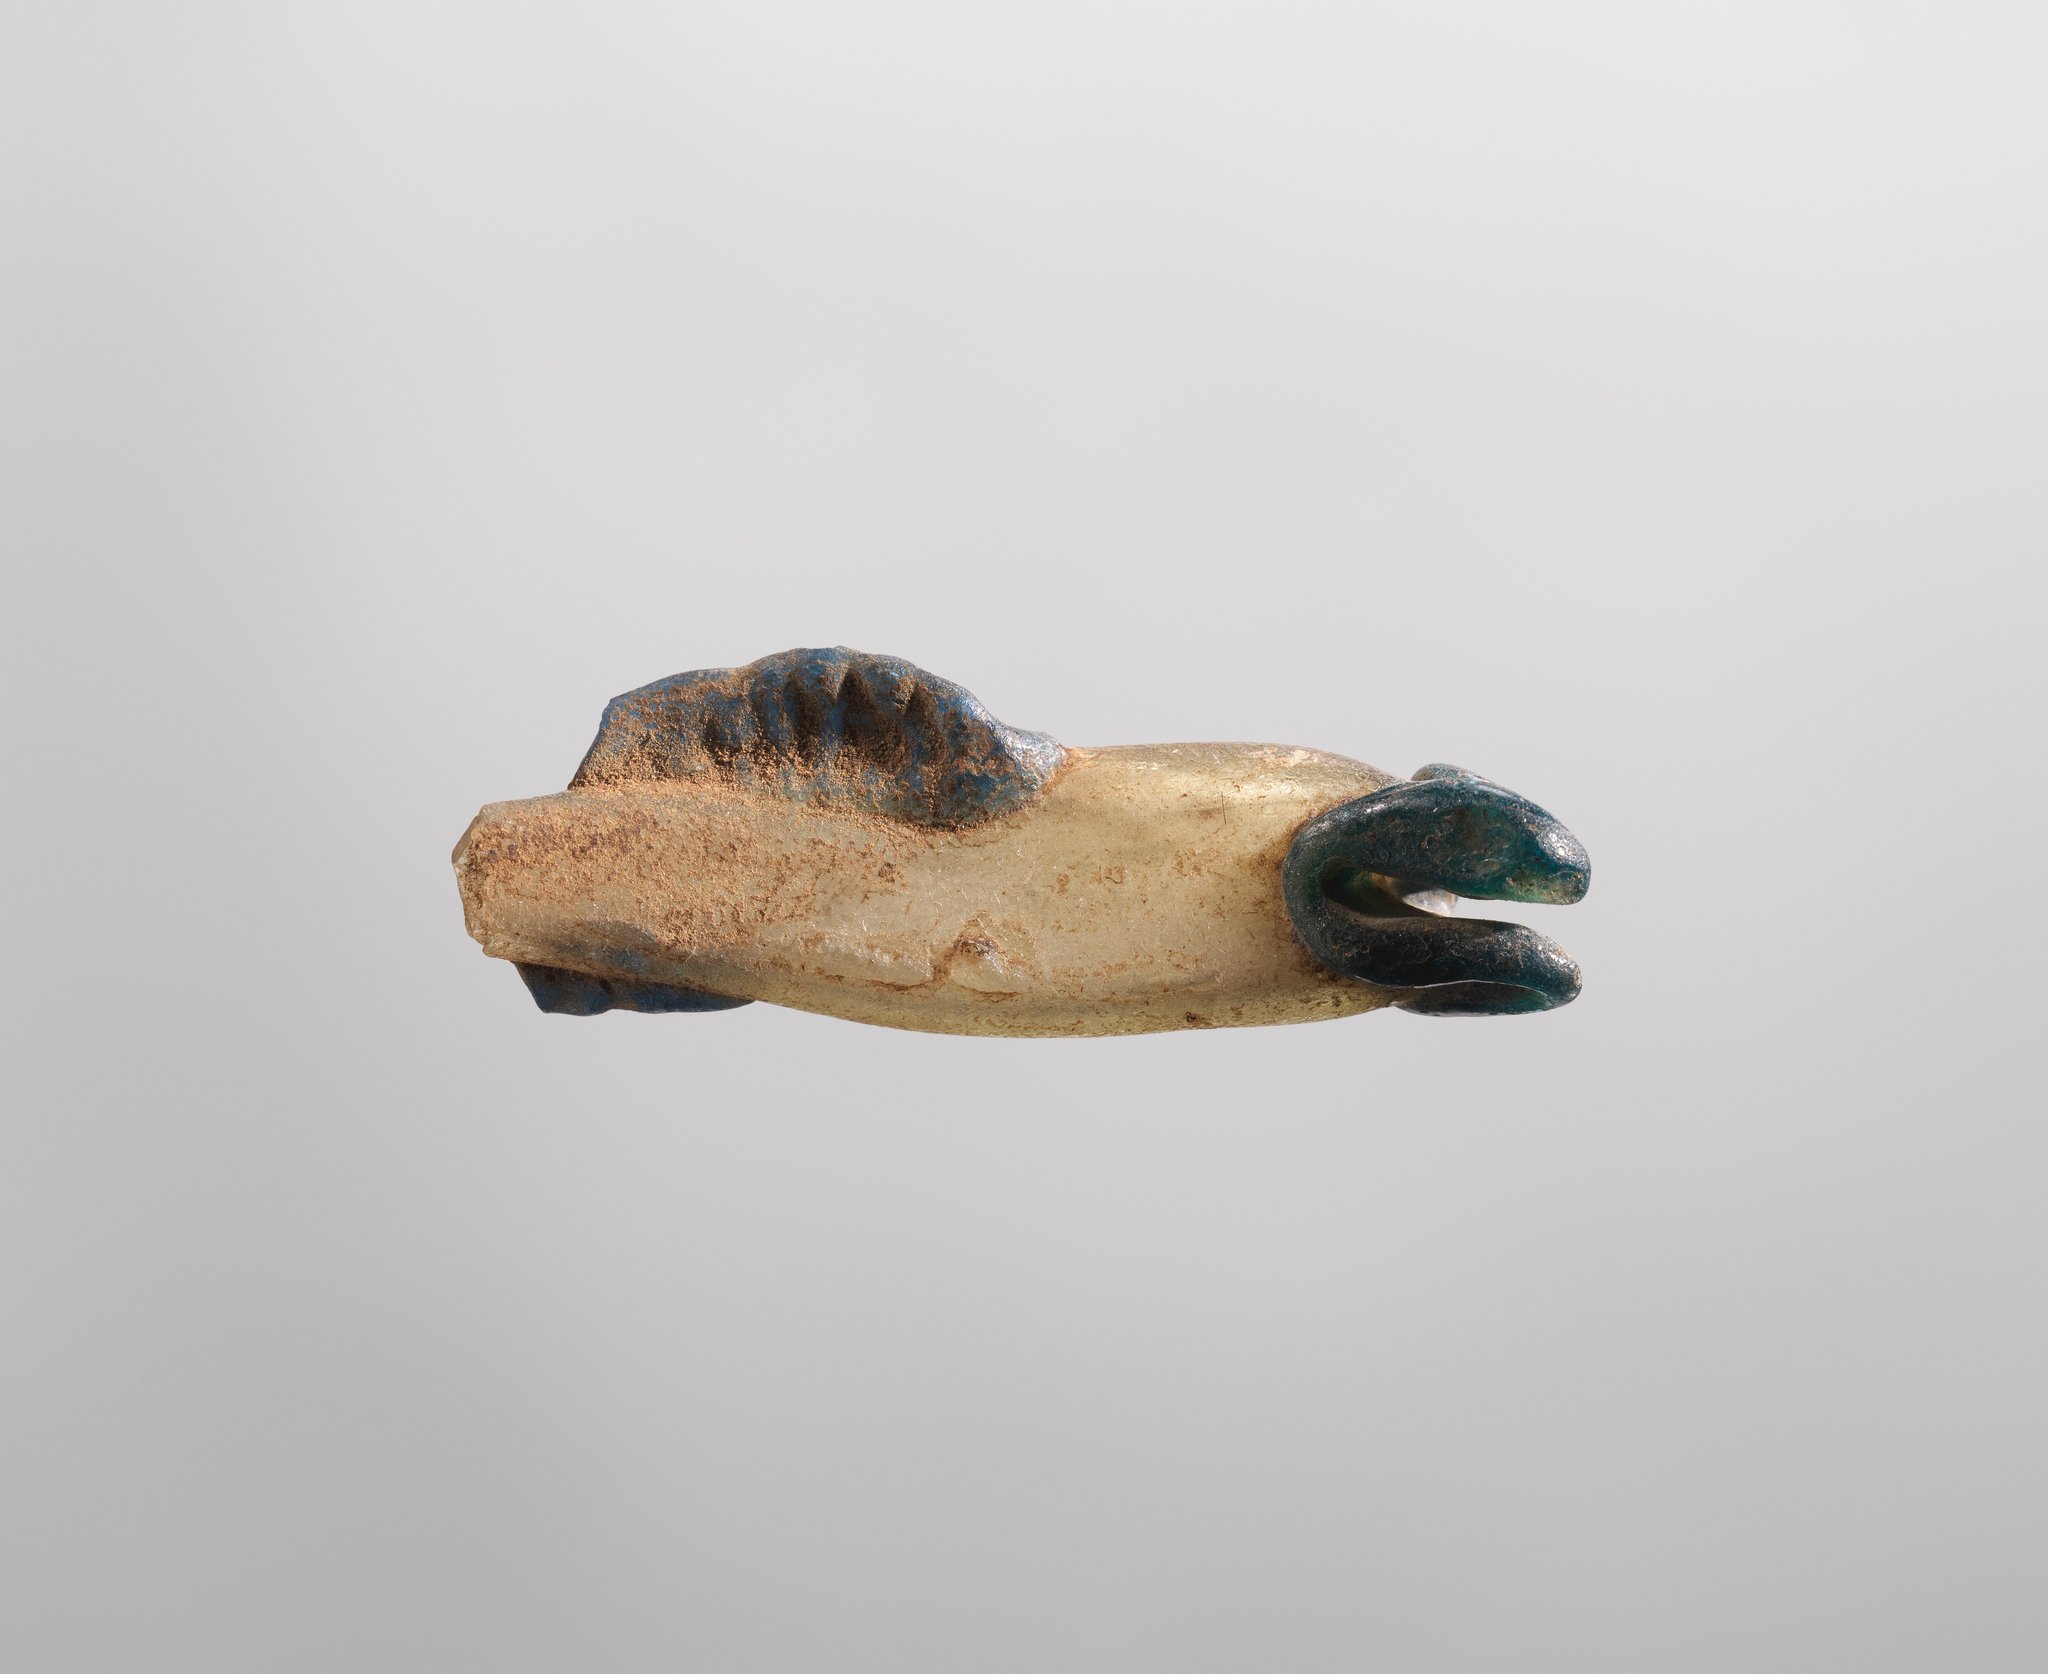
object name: fish, appliqué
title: Fish appliqué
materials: glass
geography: egypt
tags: fish